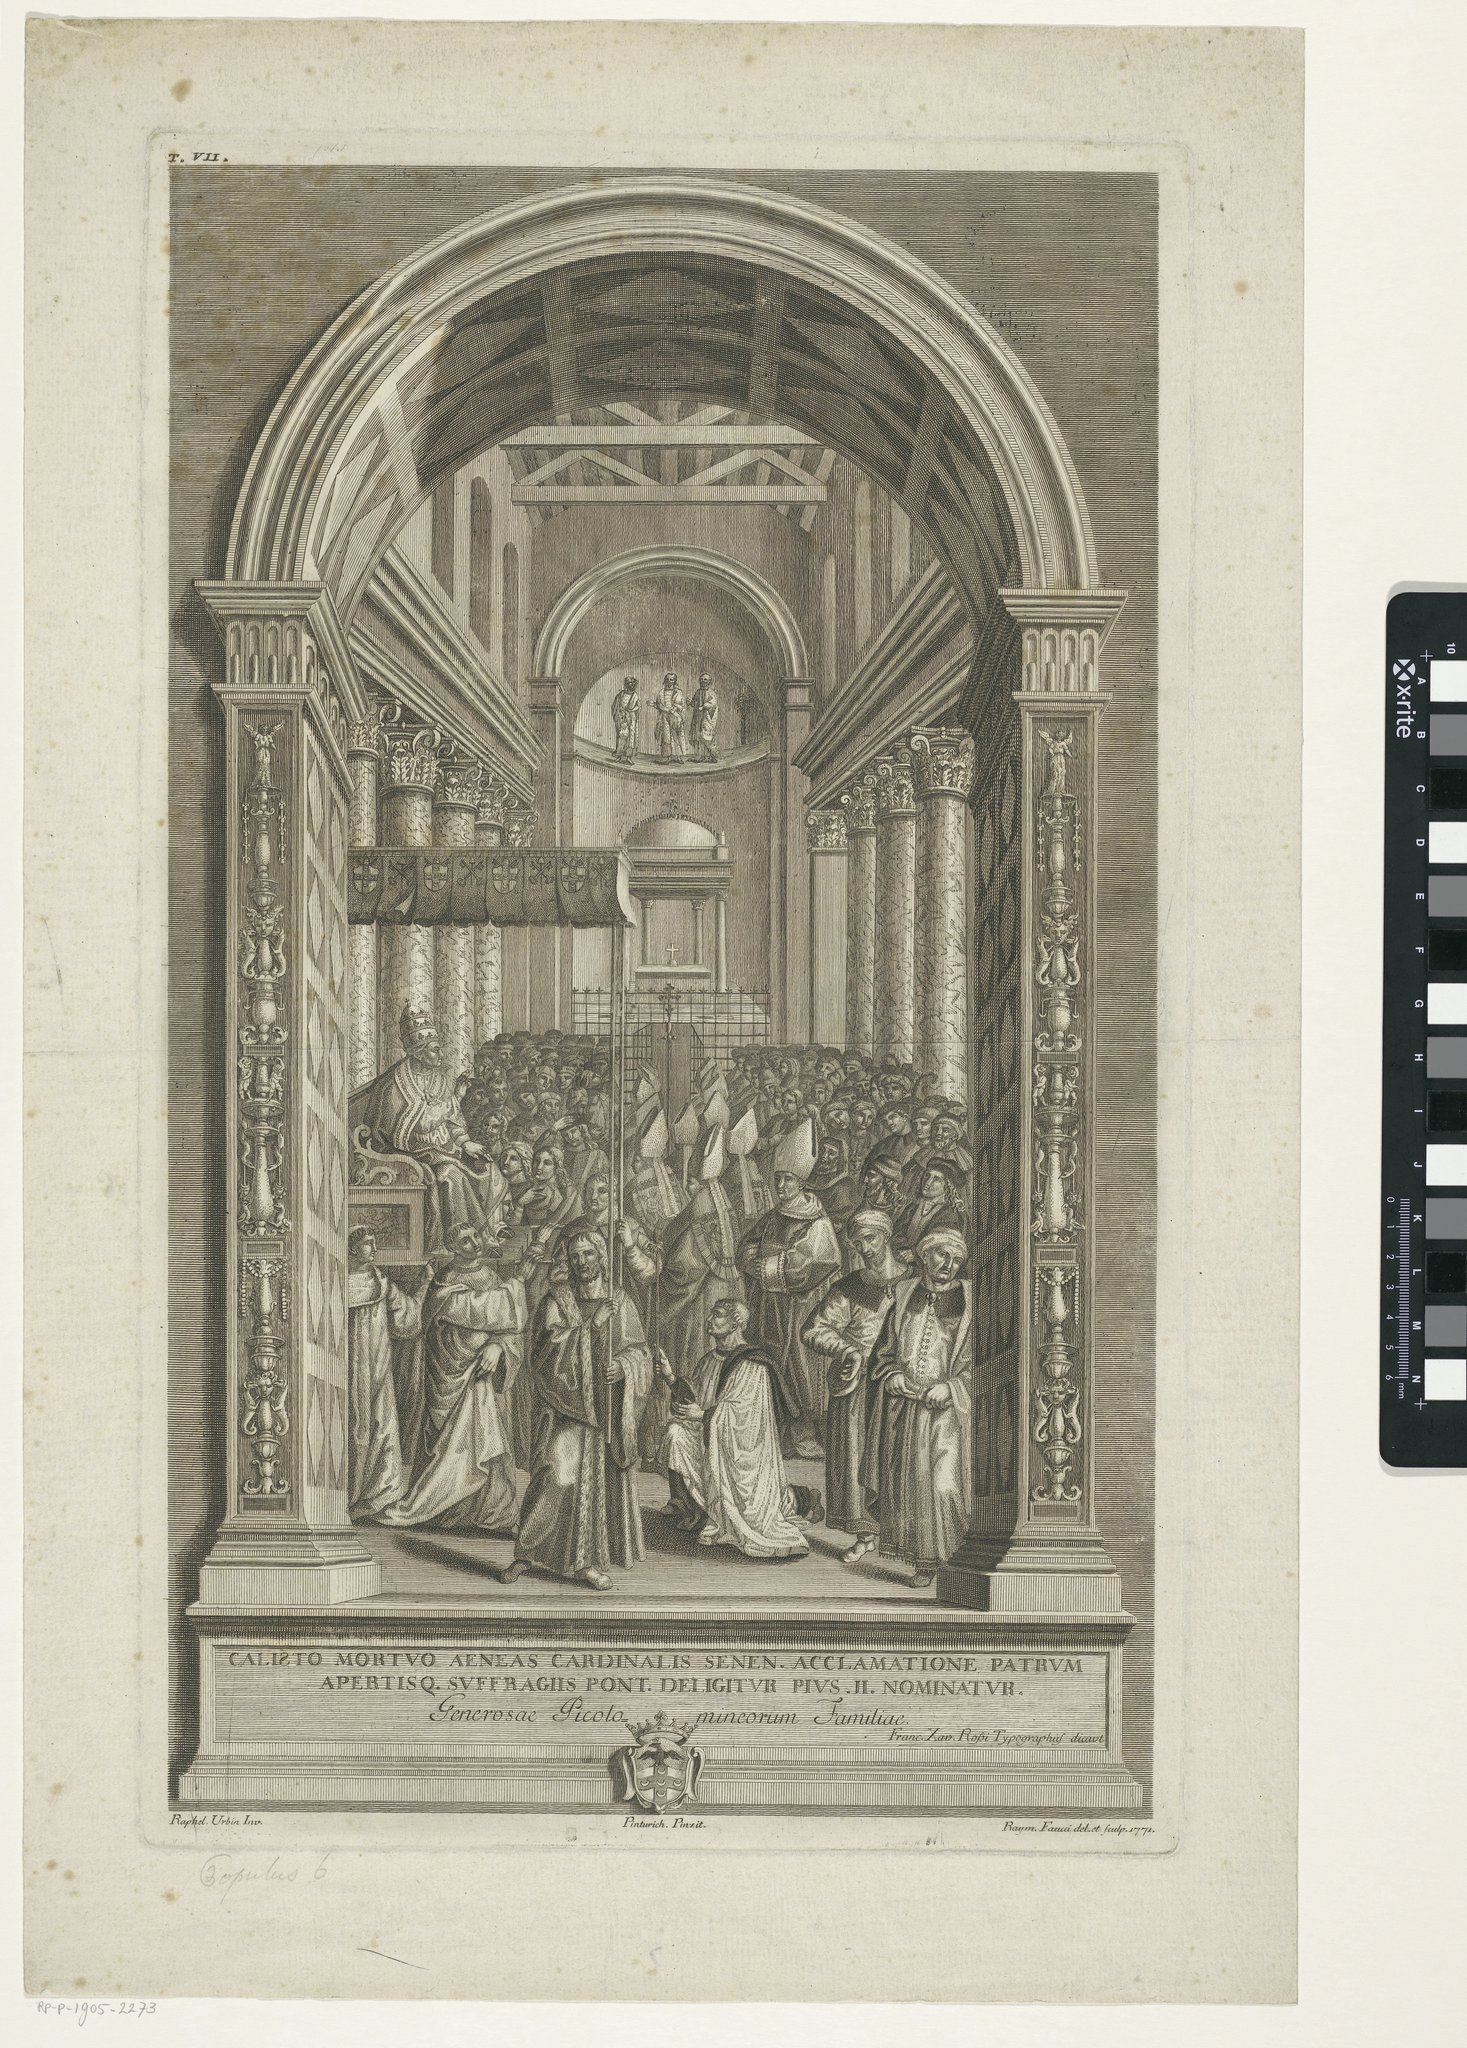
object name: print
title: Enea Silvio Piccolomini uitgeroepen tot paus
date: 1771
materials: paper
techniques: engraving, etching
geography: italy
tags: rome, cardinal, interior of church, pope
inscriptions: collector's mark: Lugt 2228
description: Zicht in een kerk waar Enea Silvio Piccolomini wordt uitgeroepen tot paus. Links zit hij als paus Pius II op een sedia gestatoria (pauselijke draagstoel) onder een baldakijn, en maakt een zegenend gebaar. Voor hem een menigte toeschouwers en geestelijken. Genummerd linksboven: T. VII.